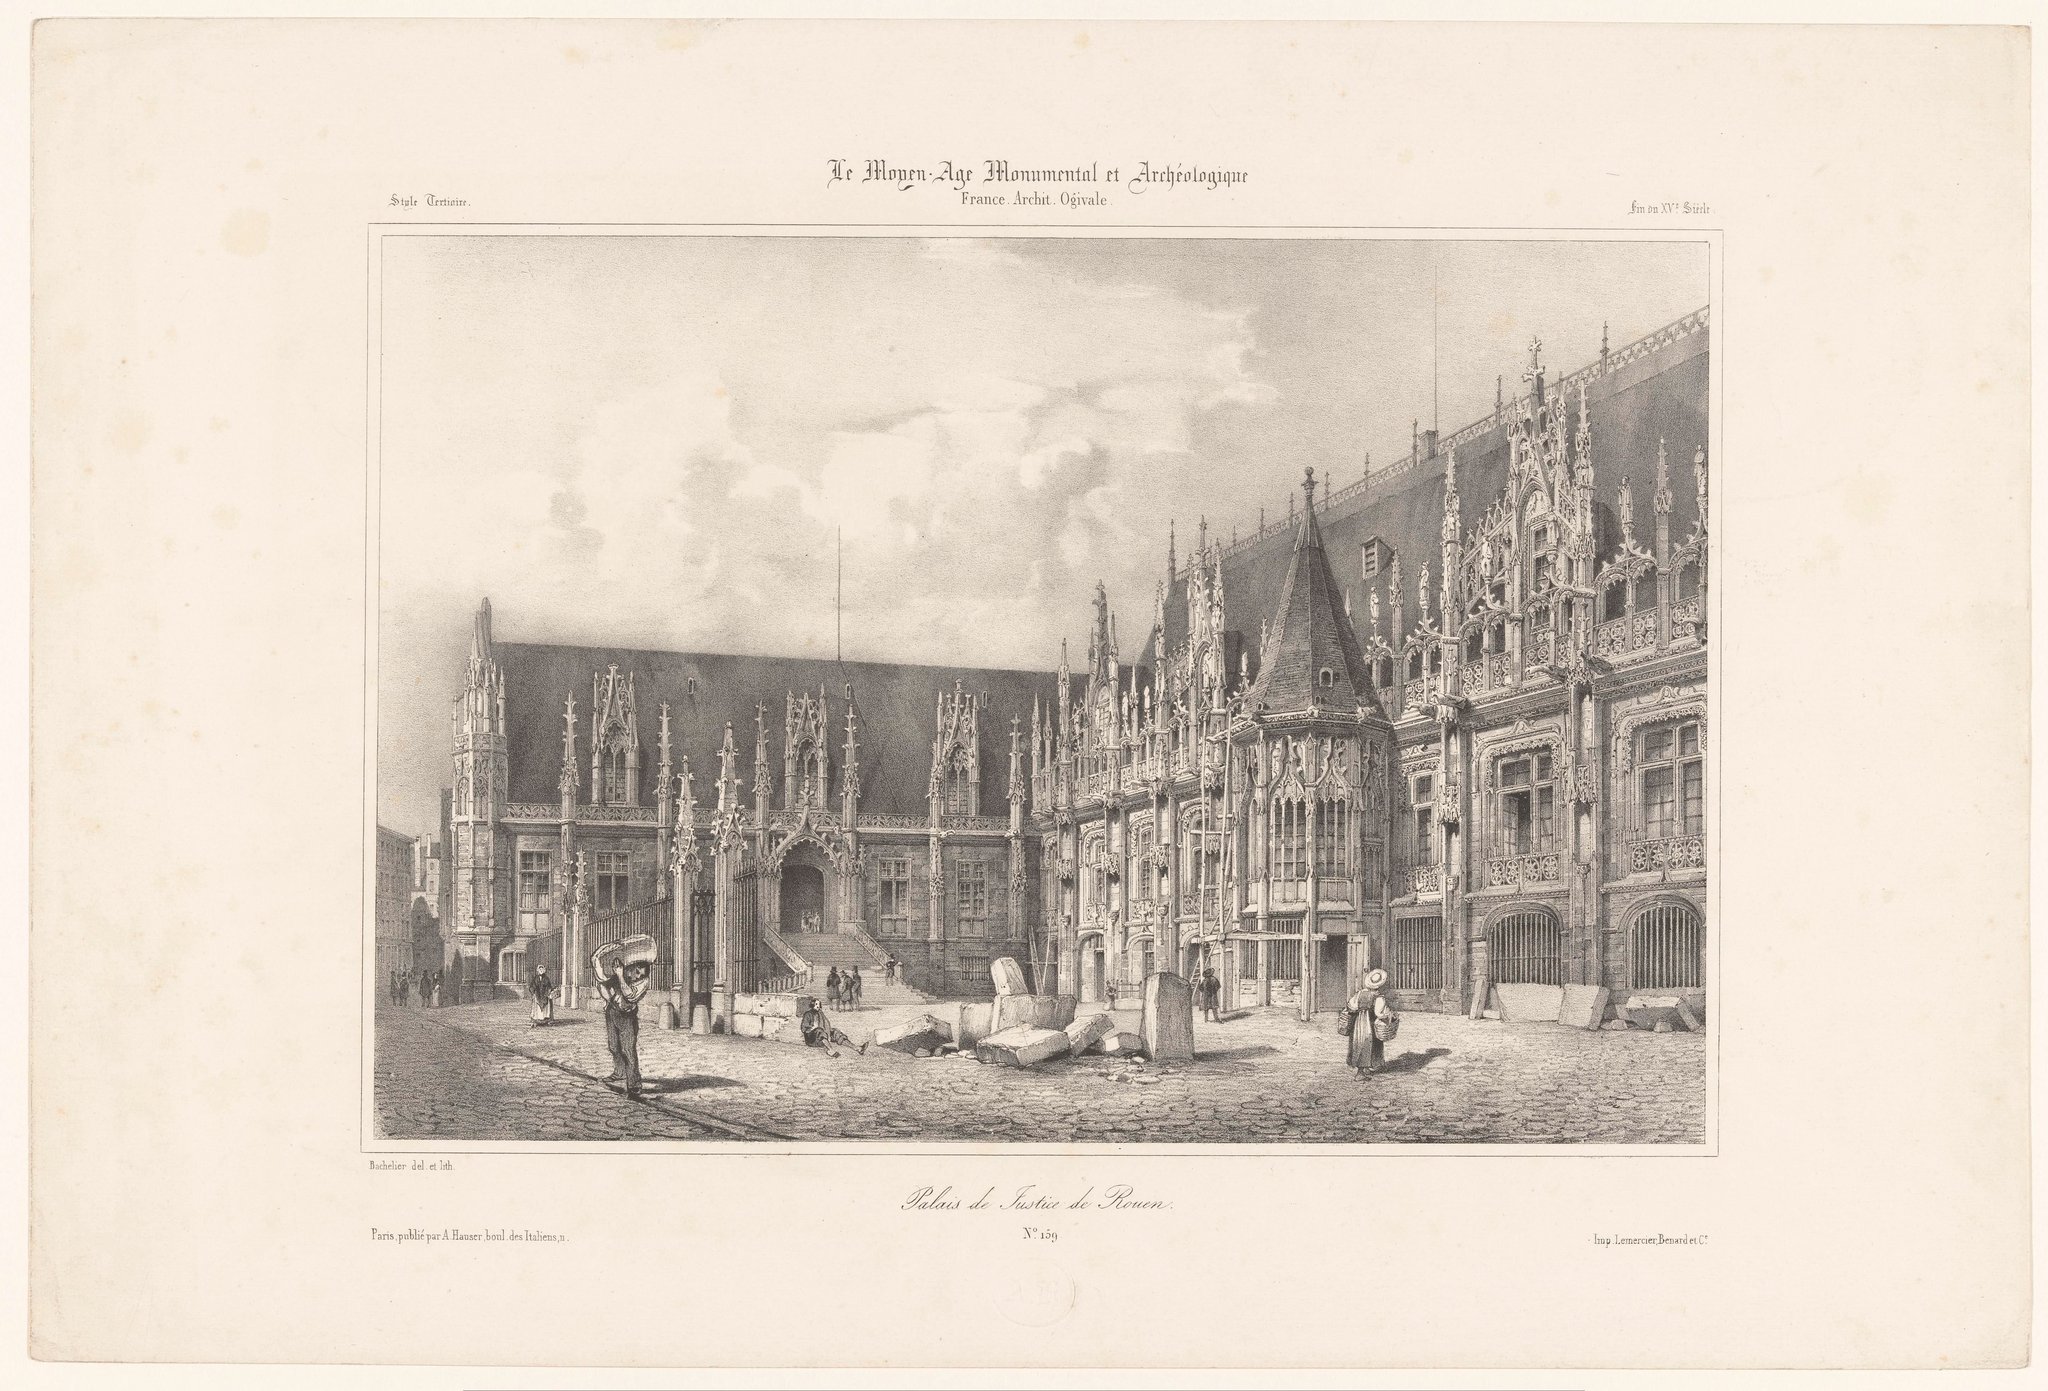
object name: print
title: Palais de Justice de Rouen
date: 1840-1851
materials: paper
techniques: lithograph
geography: paris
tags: court building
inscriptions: collector's mark: Lugt 2228a, check stamp: Lugt 4210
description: Deze serie bestaat uit in ieder geval 431 en mogelijk meer prenten. De serie werd in verschillende 'livraisons' uitgegeven tussen 1840 en 1851. Gebaseerd op vermeldingen in 'Bibliographie de la France' (via http://artfl-project.uchicago.edu/content/image-france).